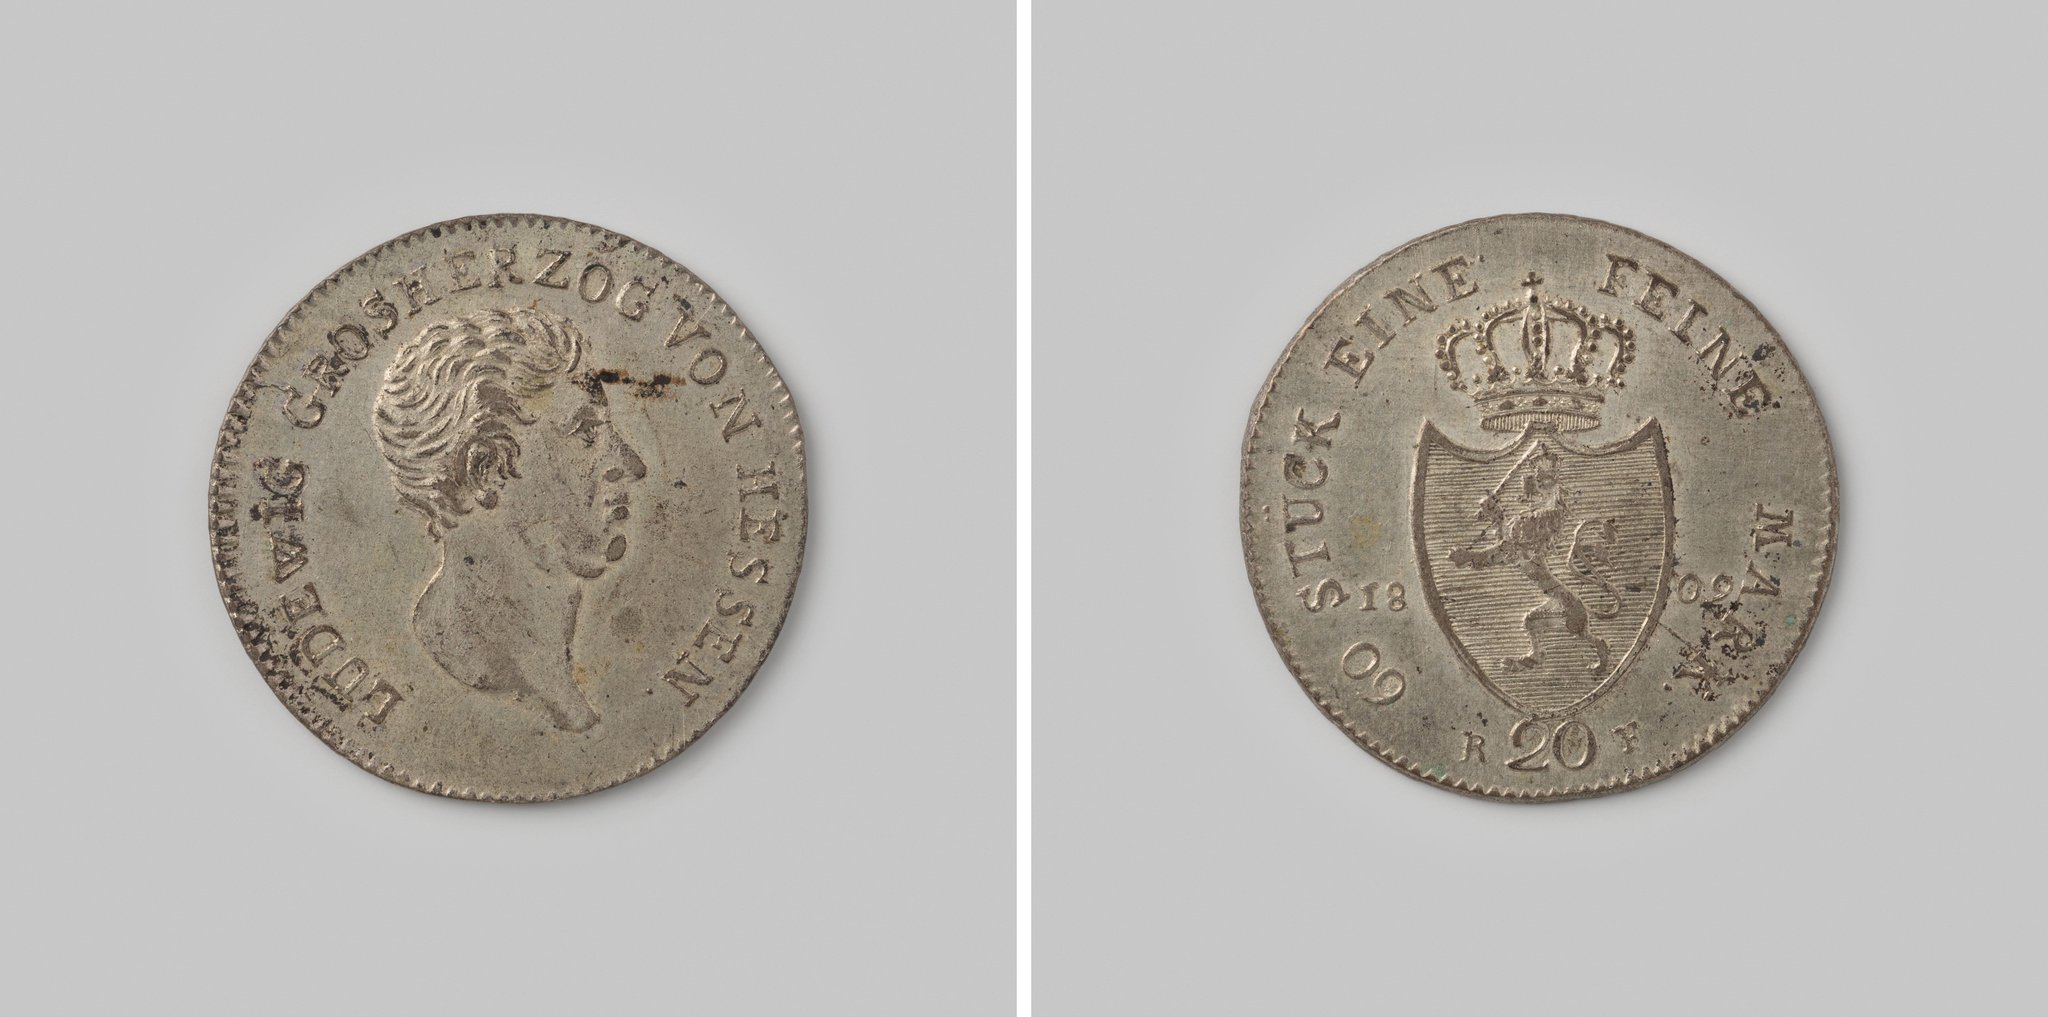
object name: coin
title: 20 Conventionskreuzer uit het groothertogdom Hessen-Darmstadt van Ludwig I, 1809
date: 1809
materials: silver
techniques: striking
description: Zilveren munt. Voorzijde: hoofd van de groothertog naar rechts. Keerzijde: tussen jaartal gekroond wapenschild. Waarde-aanduiding in het omschrift. Kartelrand.